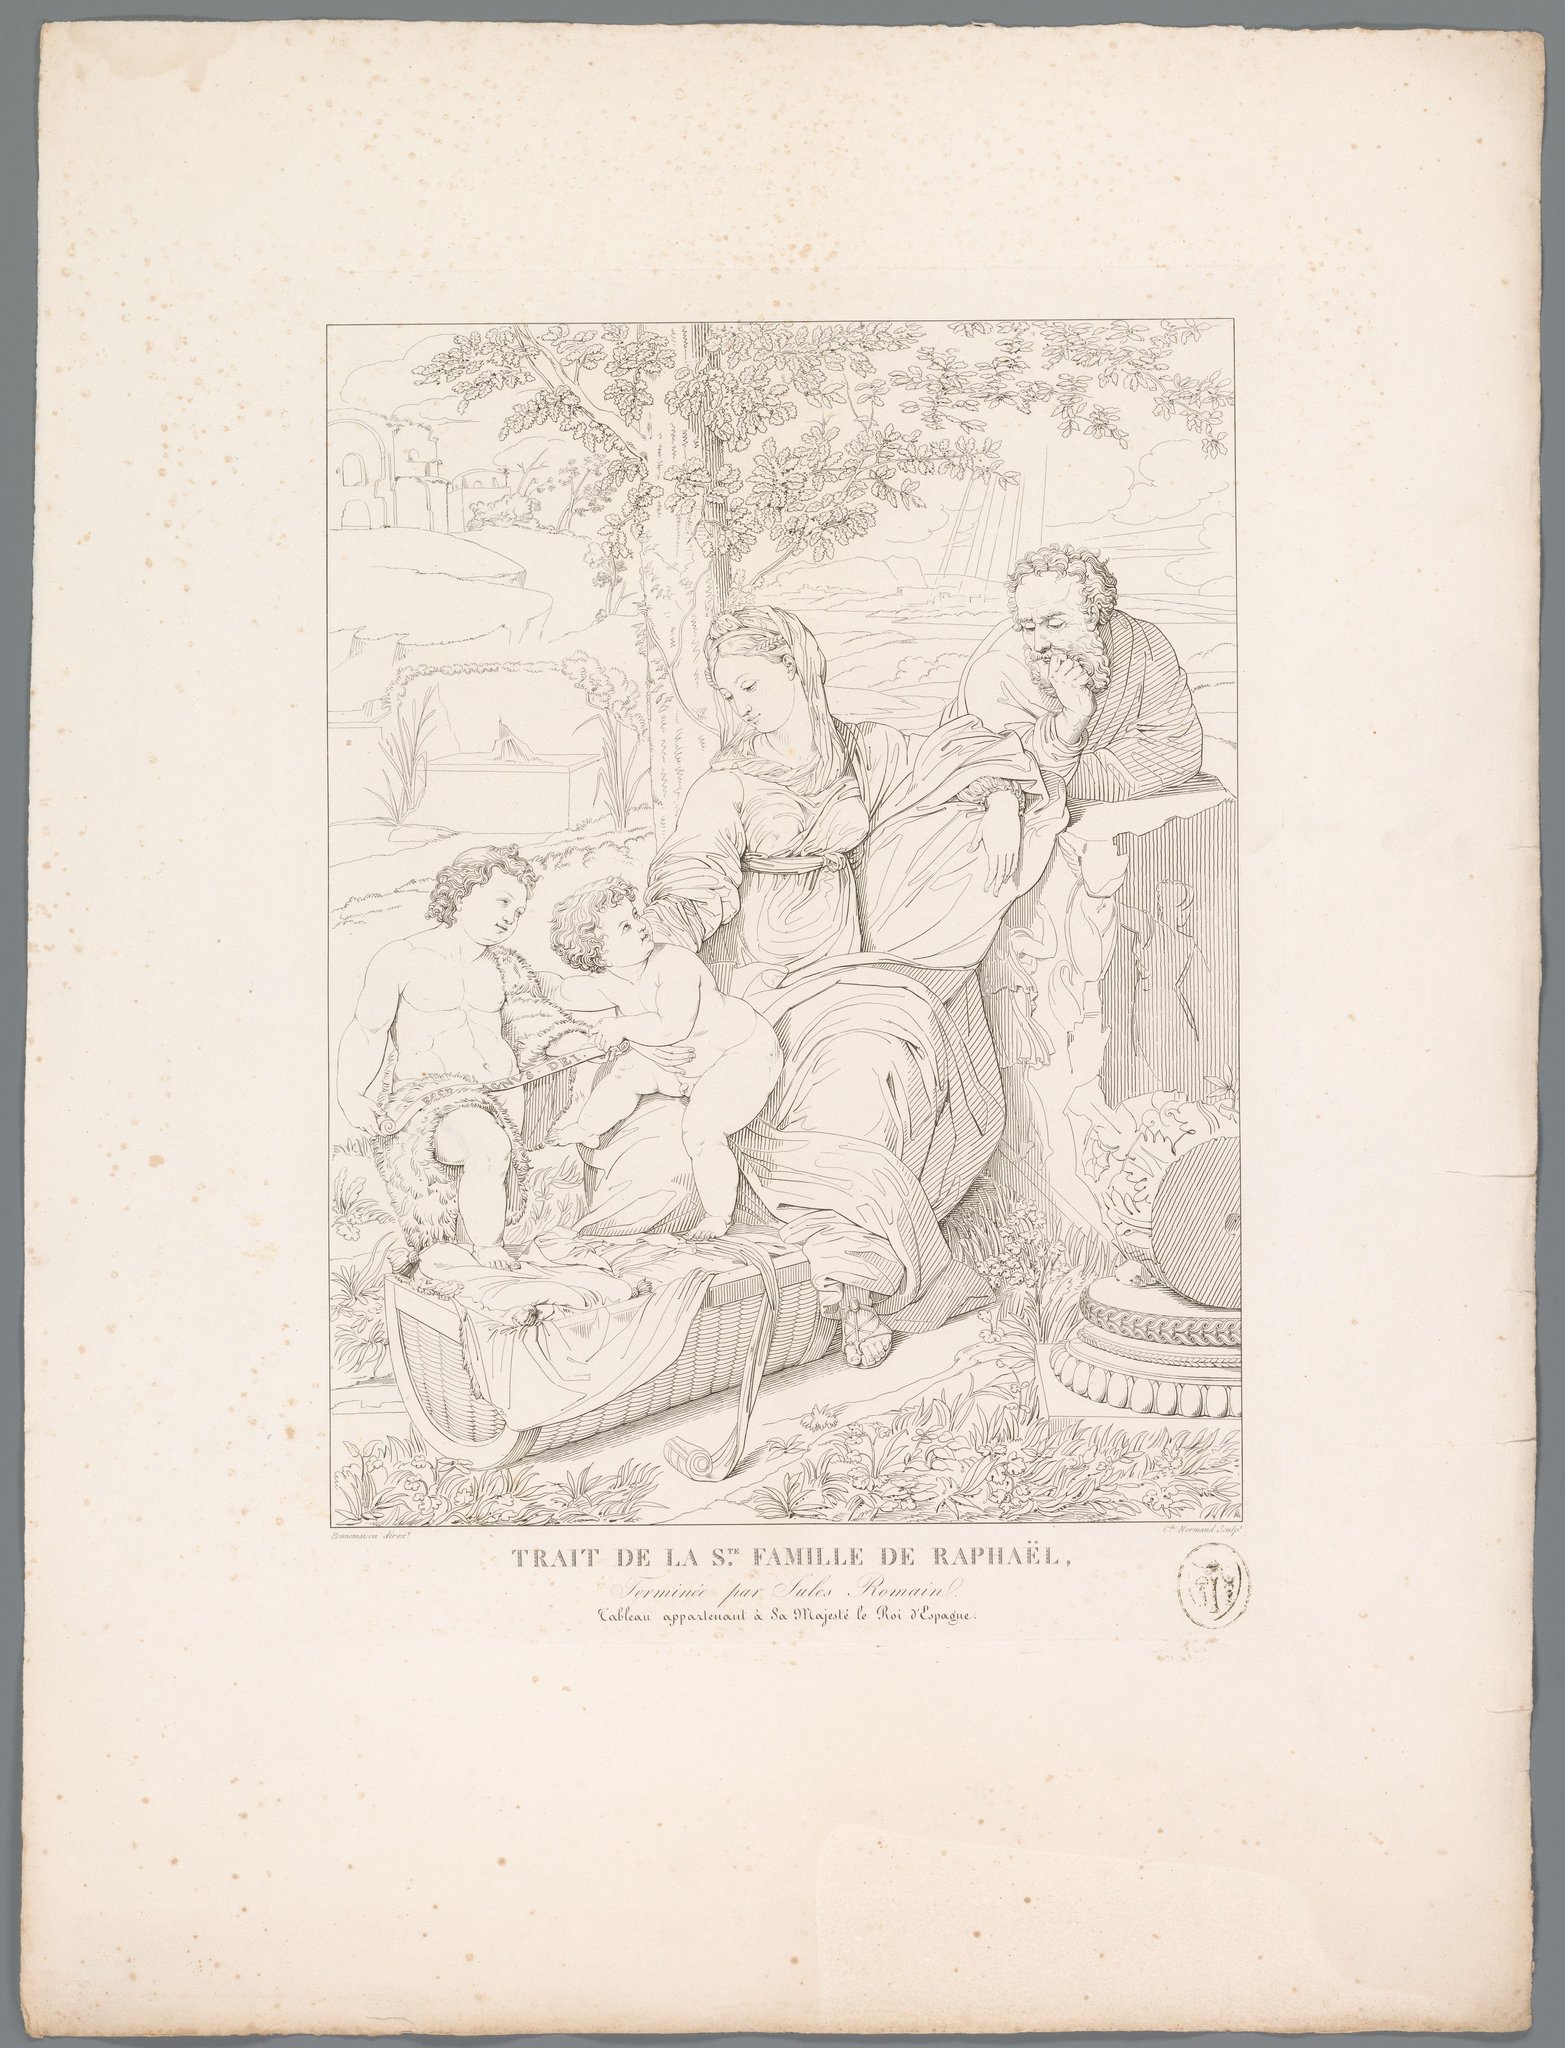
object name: print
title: Suite d'Études calquées et dessinées d'après Cinq Tableaux de Raphaël (...)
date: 1818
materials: paper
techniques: etching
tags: holy family, and derived representations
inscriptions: collector's mark: Lugt 4583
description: Maakt deel uit van een omslag met 8 prenten en 5 tekstbladen naar details van schilderijen door Rafaël. De serie kwam tot stand onder toezicht van Féréol Bonnemaison en werd voorzien van tekst door Toussaint-Bernard Émeric-David. Het geheel werd uitgegeven door Féréol Bonnemaison en Mesdemoiselles Érard te Parijs en gedrukt door Pierre I Didot in 1818. Het schilderij ook wel bekend als de 'Madonna della Quercia', bevindt zich in het Museo del Prado te Madrid, inv.nr. P000303.